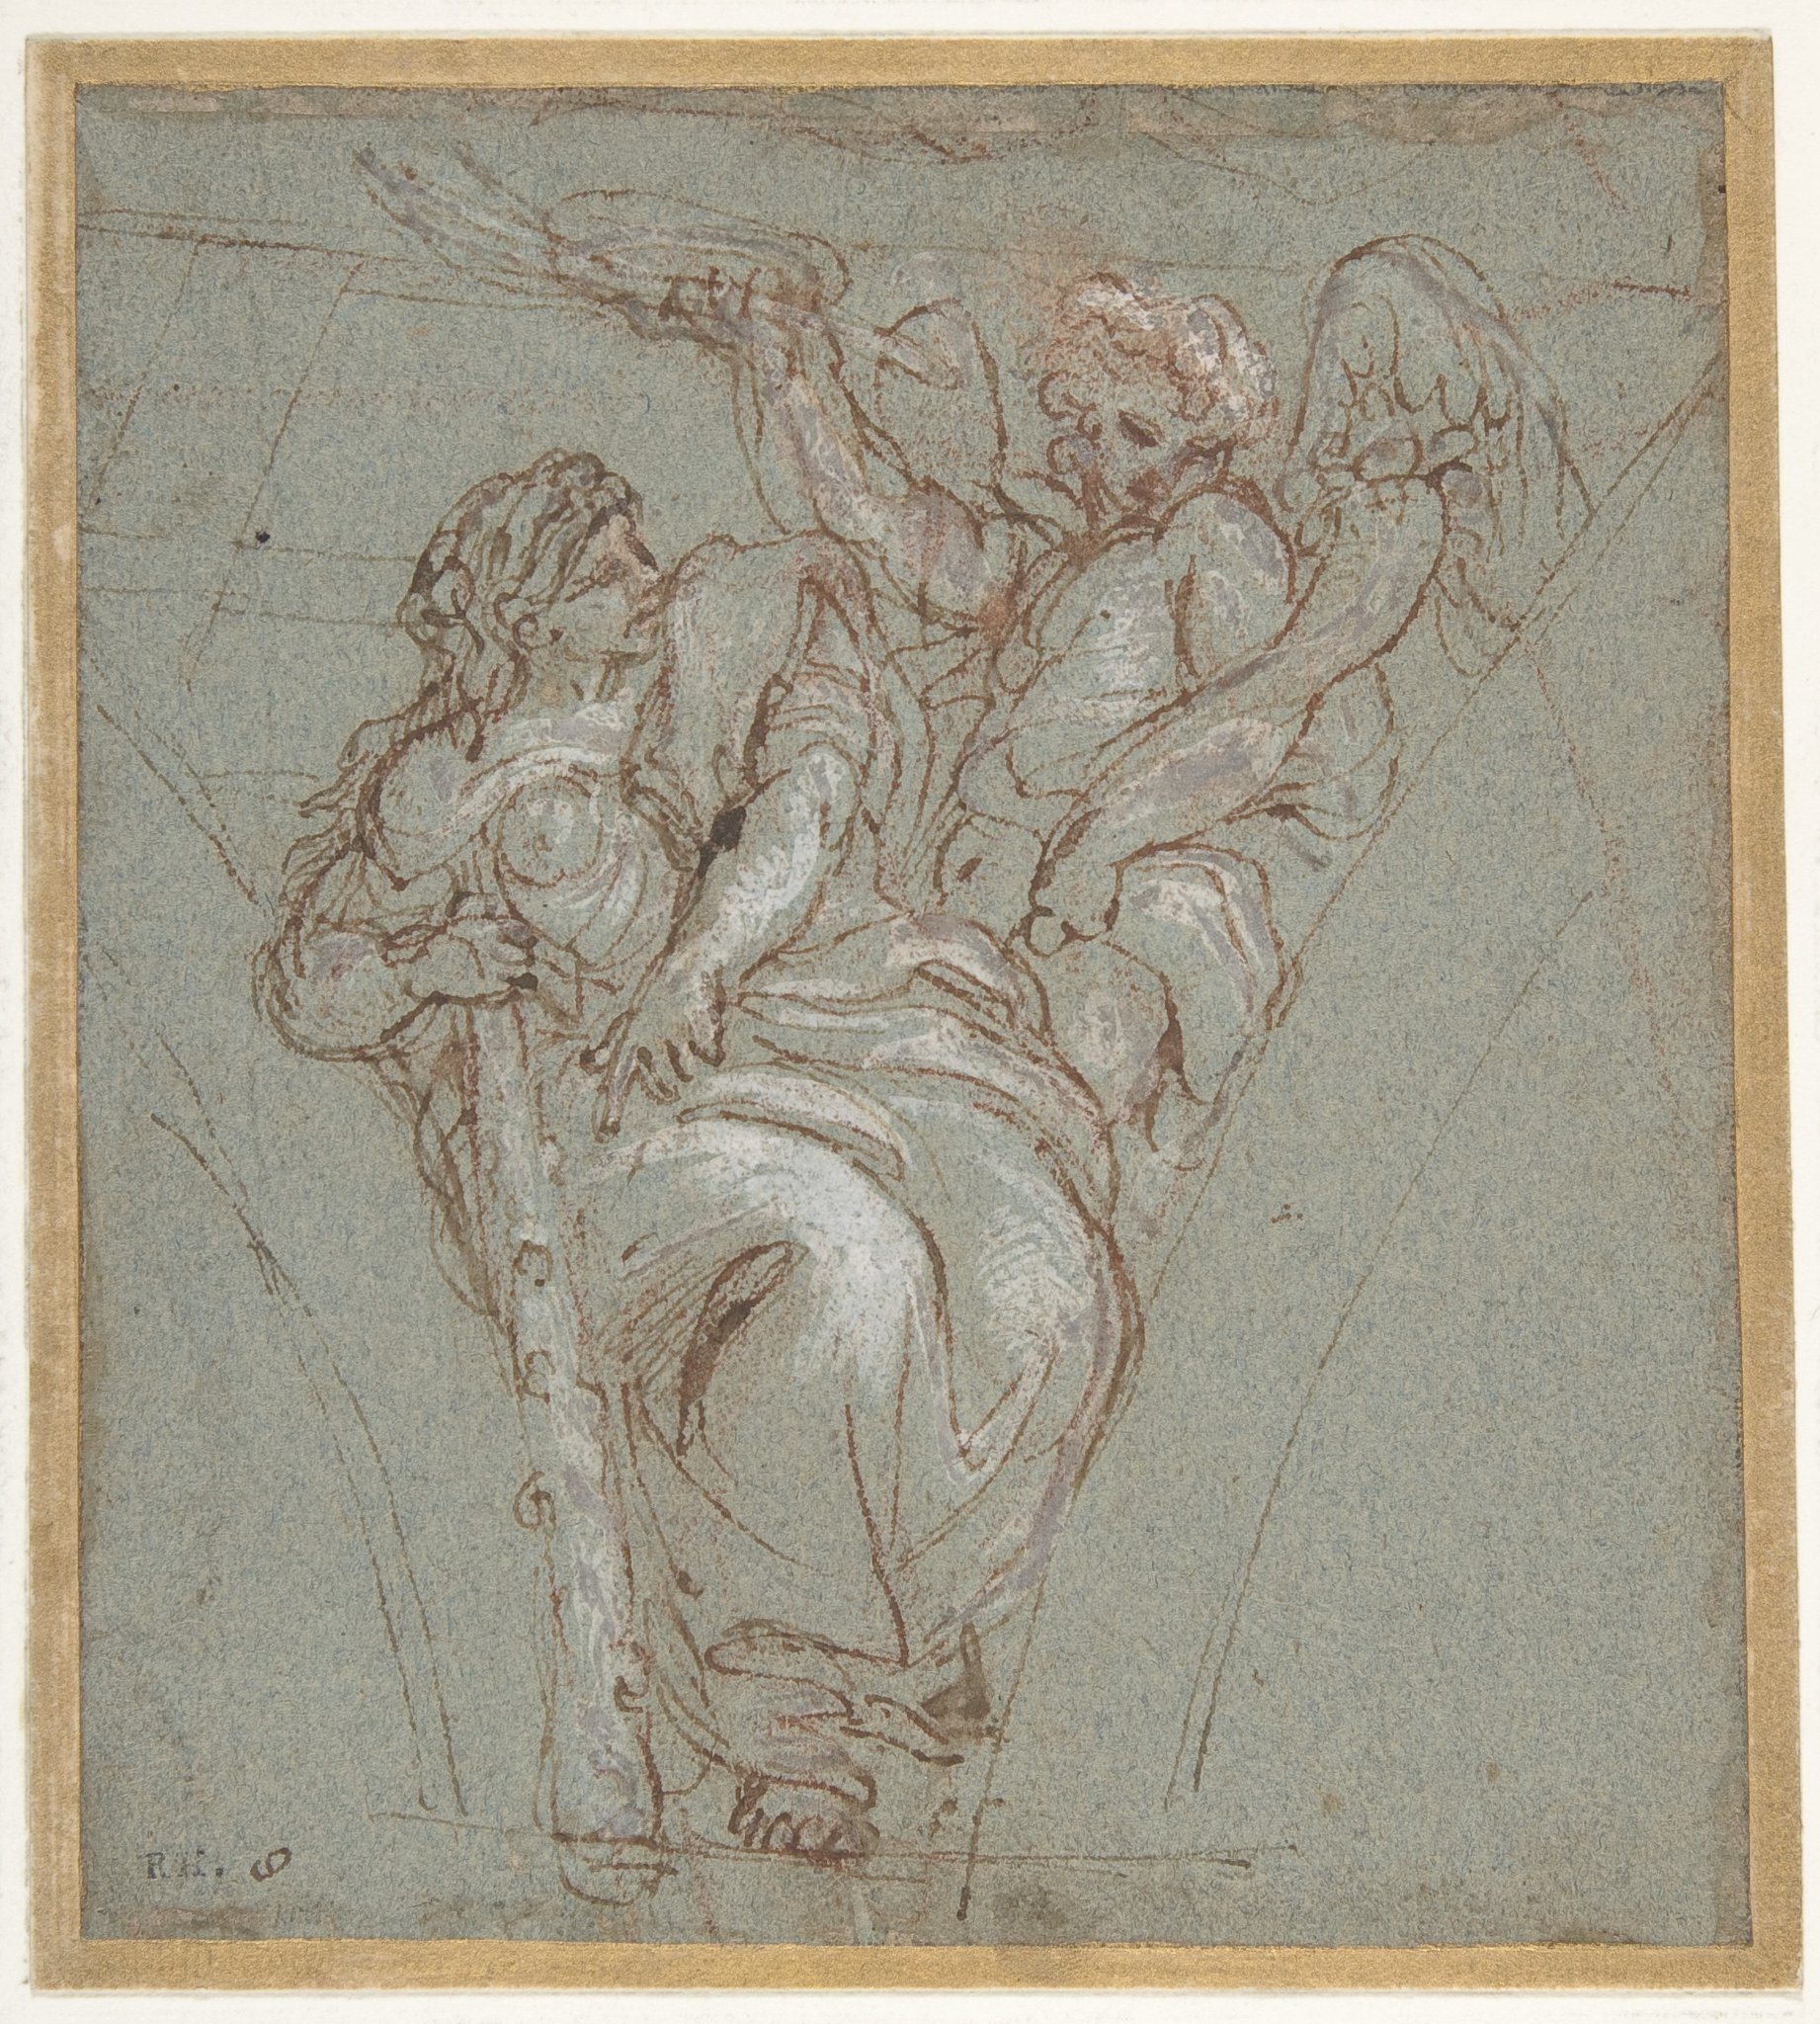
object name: drawing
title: Virtue Crowned by Honor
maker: carlo maratti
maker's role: artist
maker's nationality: italian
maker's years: 1625-1713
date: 1670-1676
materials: chalk, gouache, ink, paper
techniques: highlighting, pen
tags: men,cornucopia